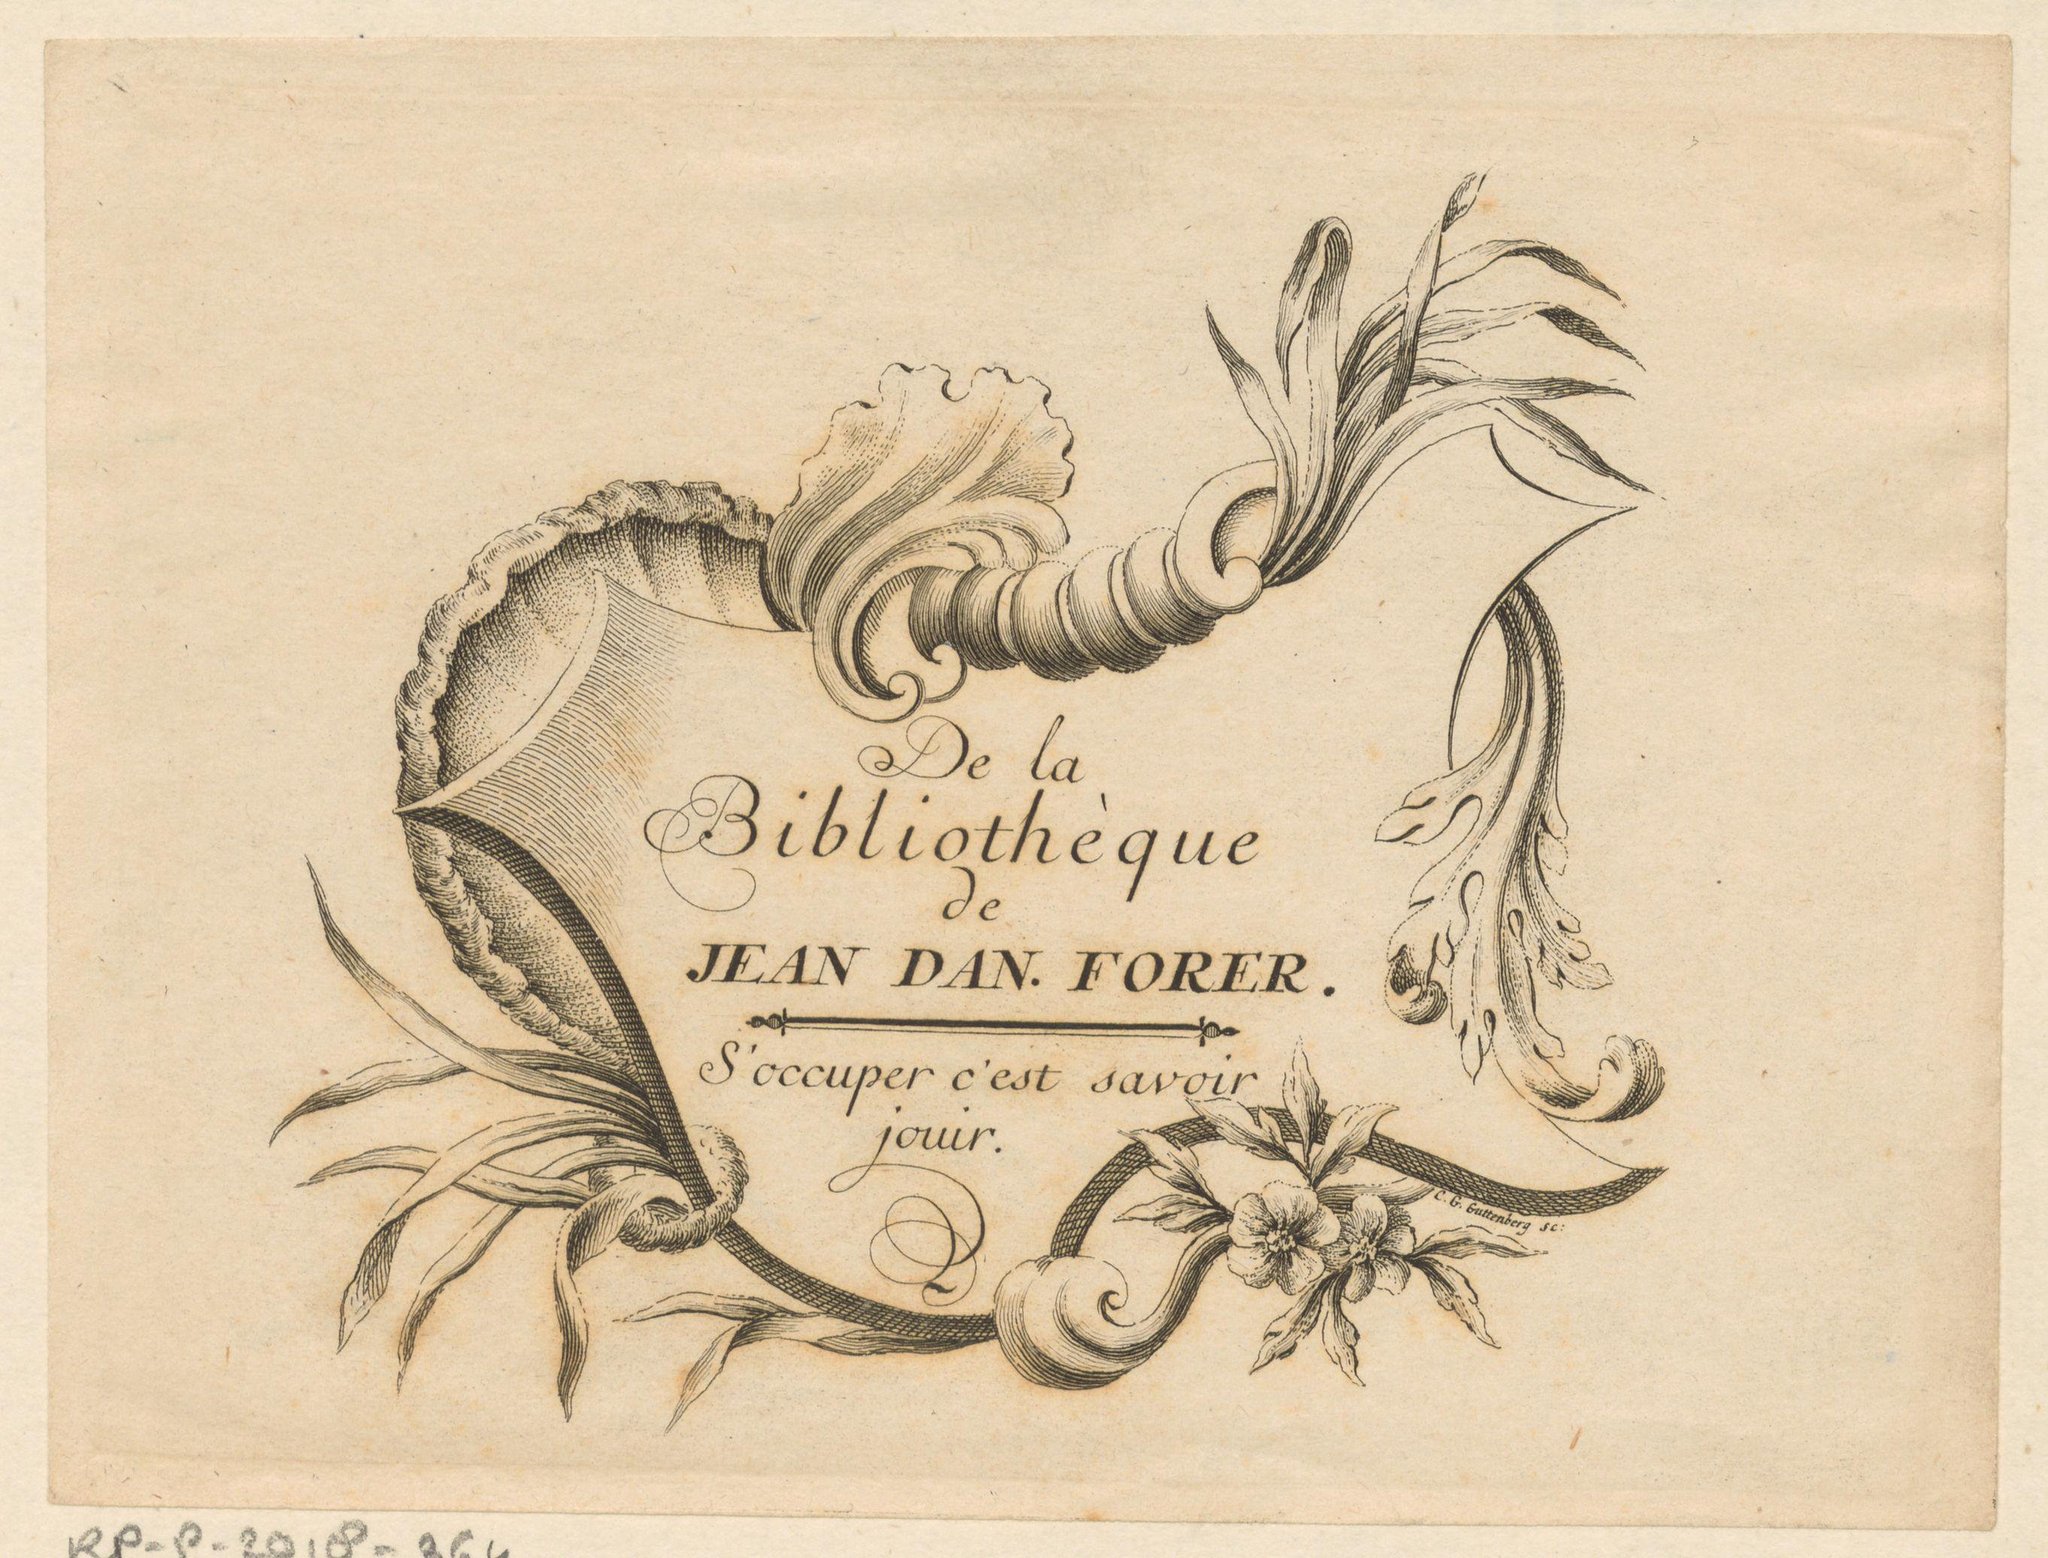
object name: bookplate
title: Ex libris van Jean Daniël Forer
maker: carl gottlieb guttenberg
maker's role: print maker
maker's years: 1743-1790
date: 1753-1790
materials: paper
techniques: engraving, etching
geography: france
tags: flowers